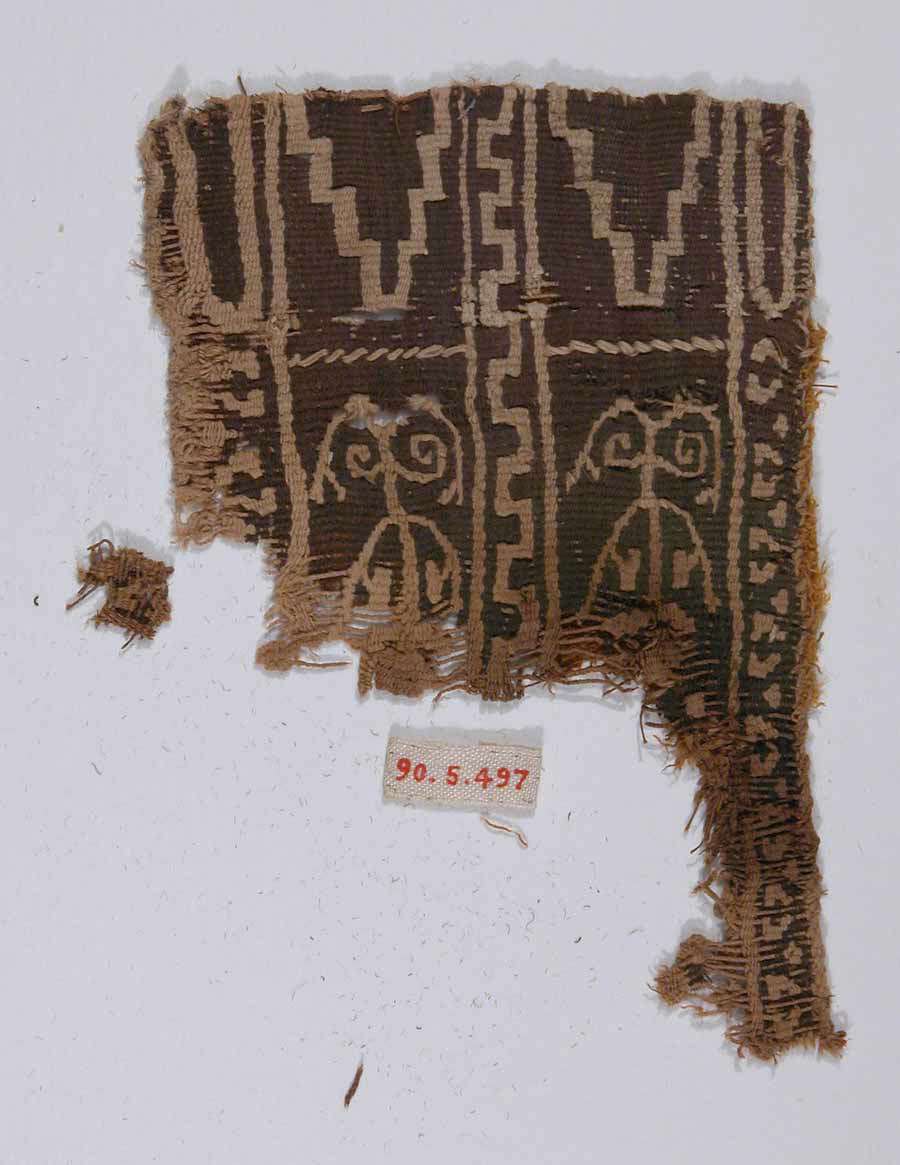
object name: textile fragment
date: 301-500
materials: linen, wool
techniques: weave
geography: egypt